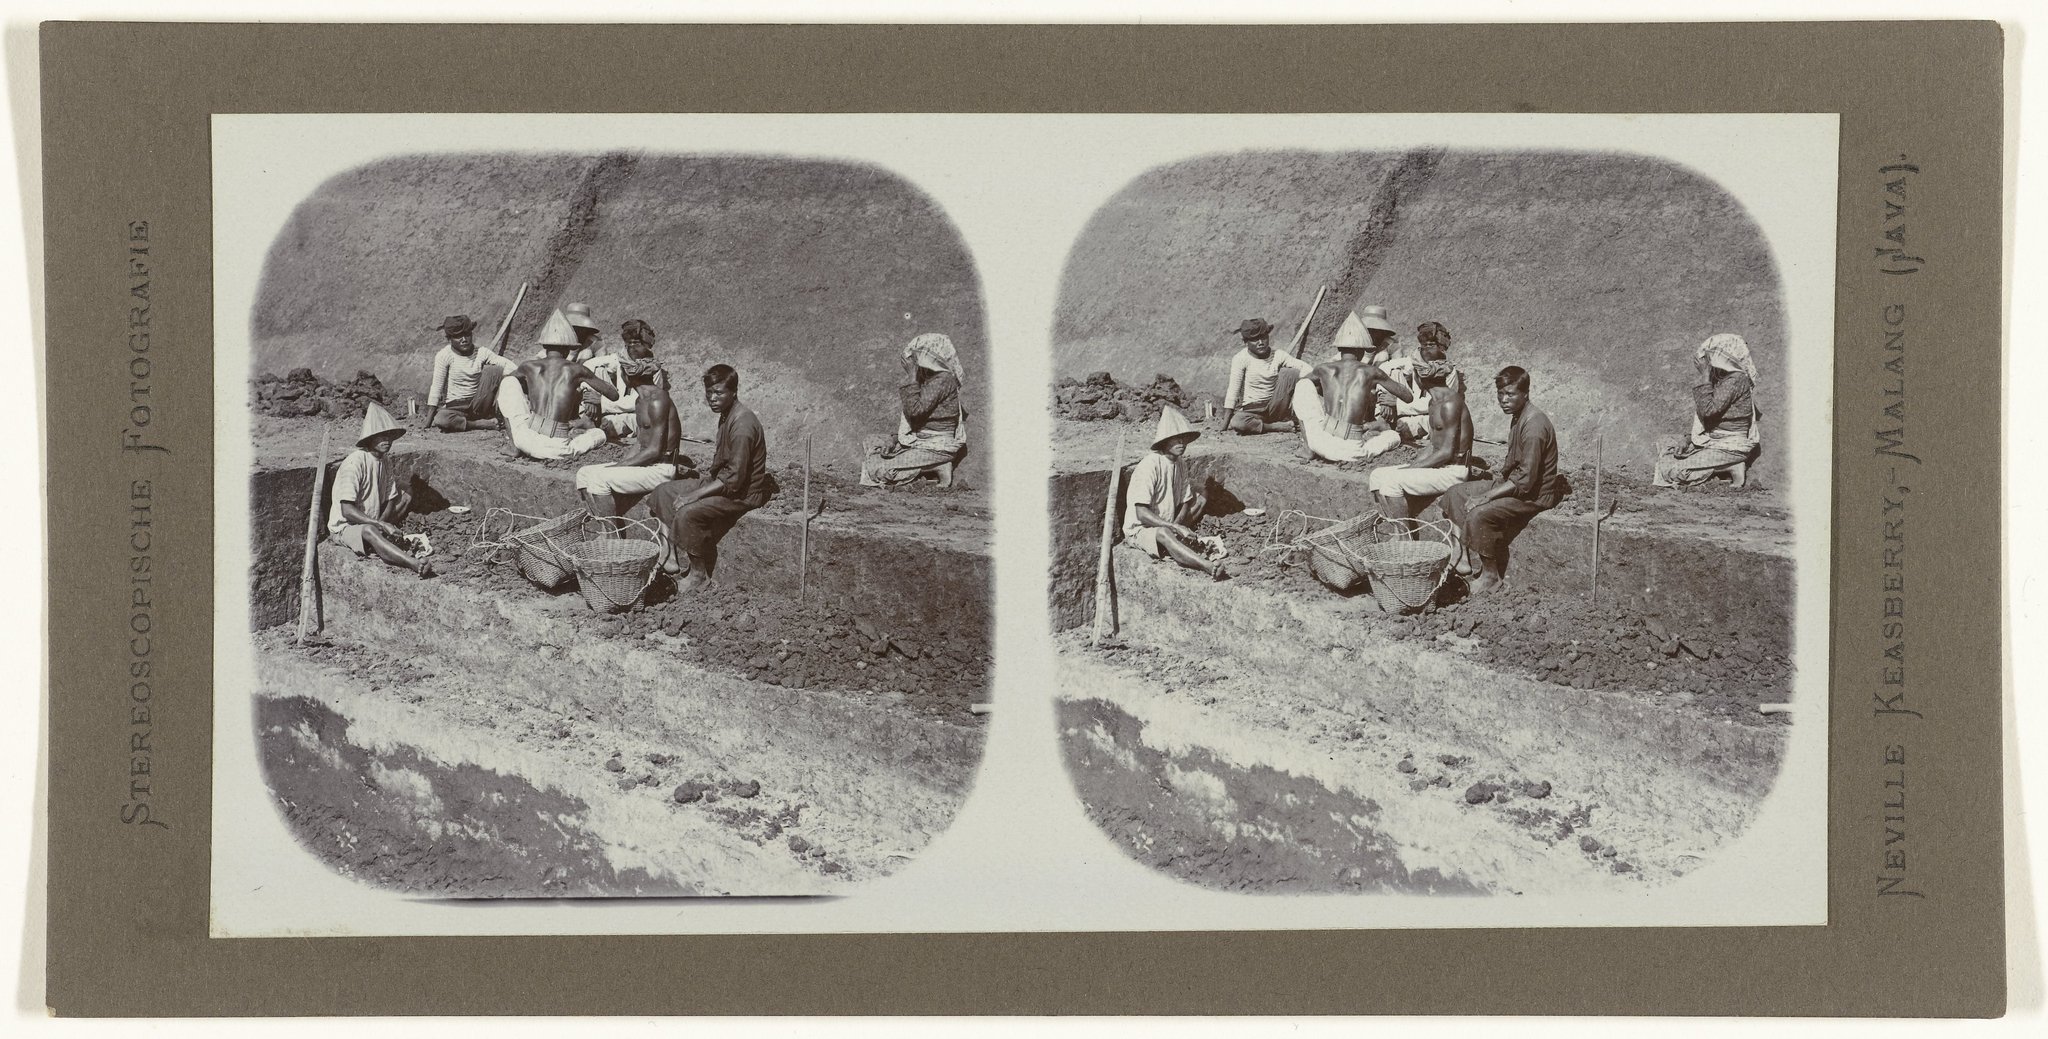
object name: stereograph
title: Groep contractarbeiders tijdens hun pauze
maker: neville keasberry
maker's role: fotograaf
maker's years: 1866-1944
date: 1900-1935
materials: cardboard, paper, photographic support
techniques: albumen print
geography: malang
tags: working class, labourers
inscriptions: inscription: ‘Stereoscopische Fotografie’, annotation: ‘S 8 No 85. Koelies aan hun ontbijt.’, signature: ‘Neville Keasberry, Malang (Java)’